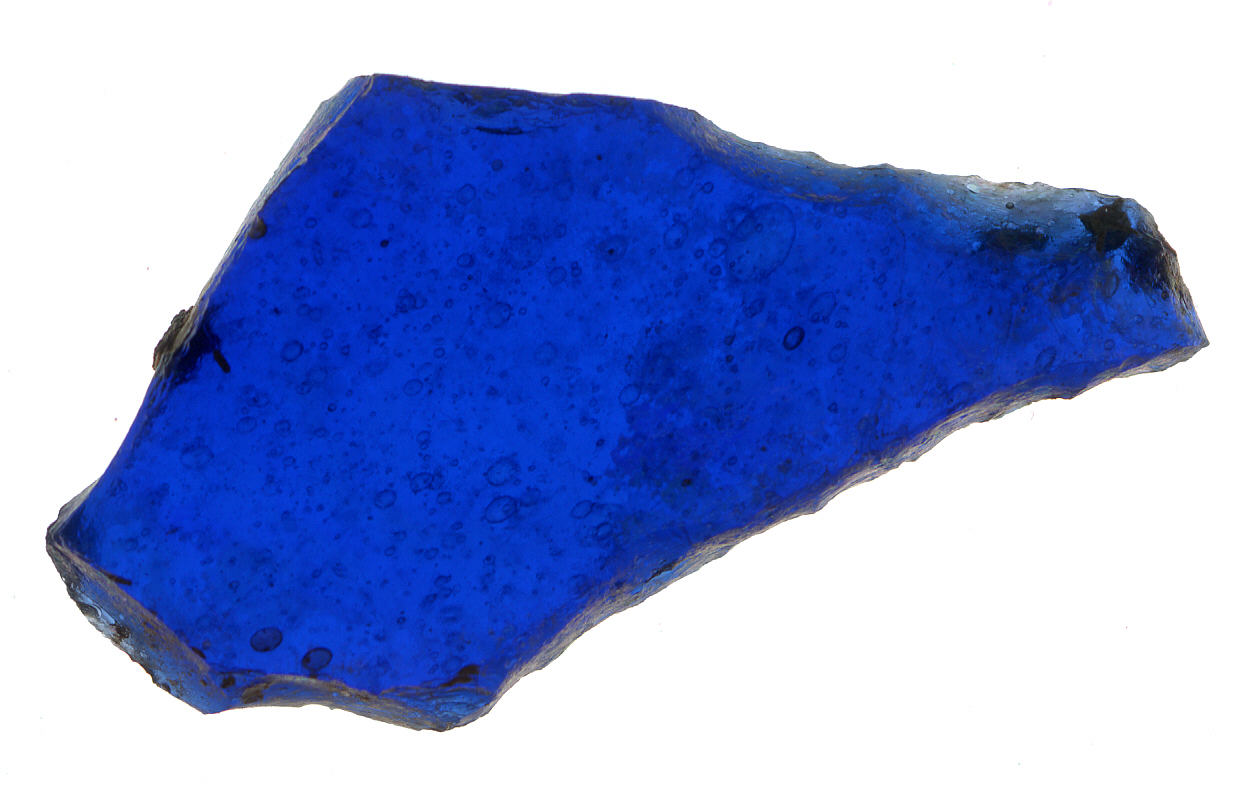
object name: fragment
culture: crusader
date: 1201-1300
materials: glass